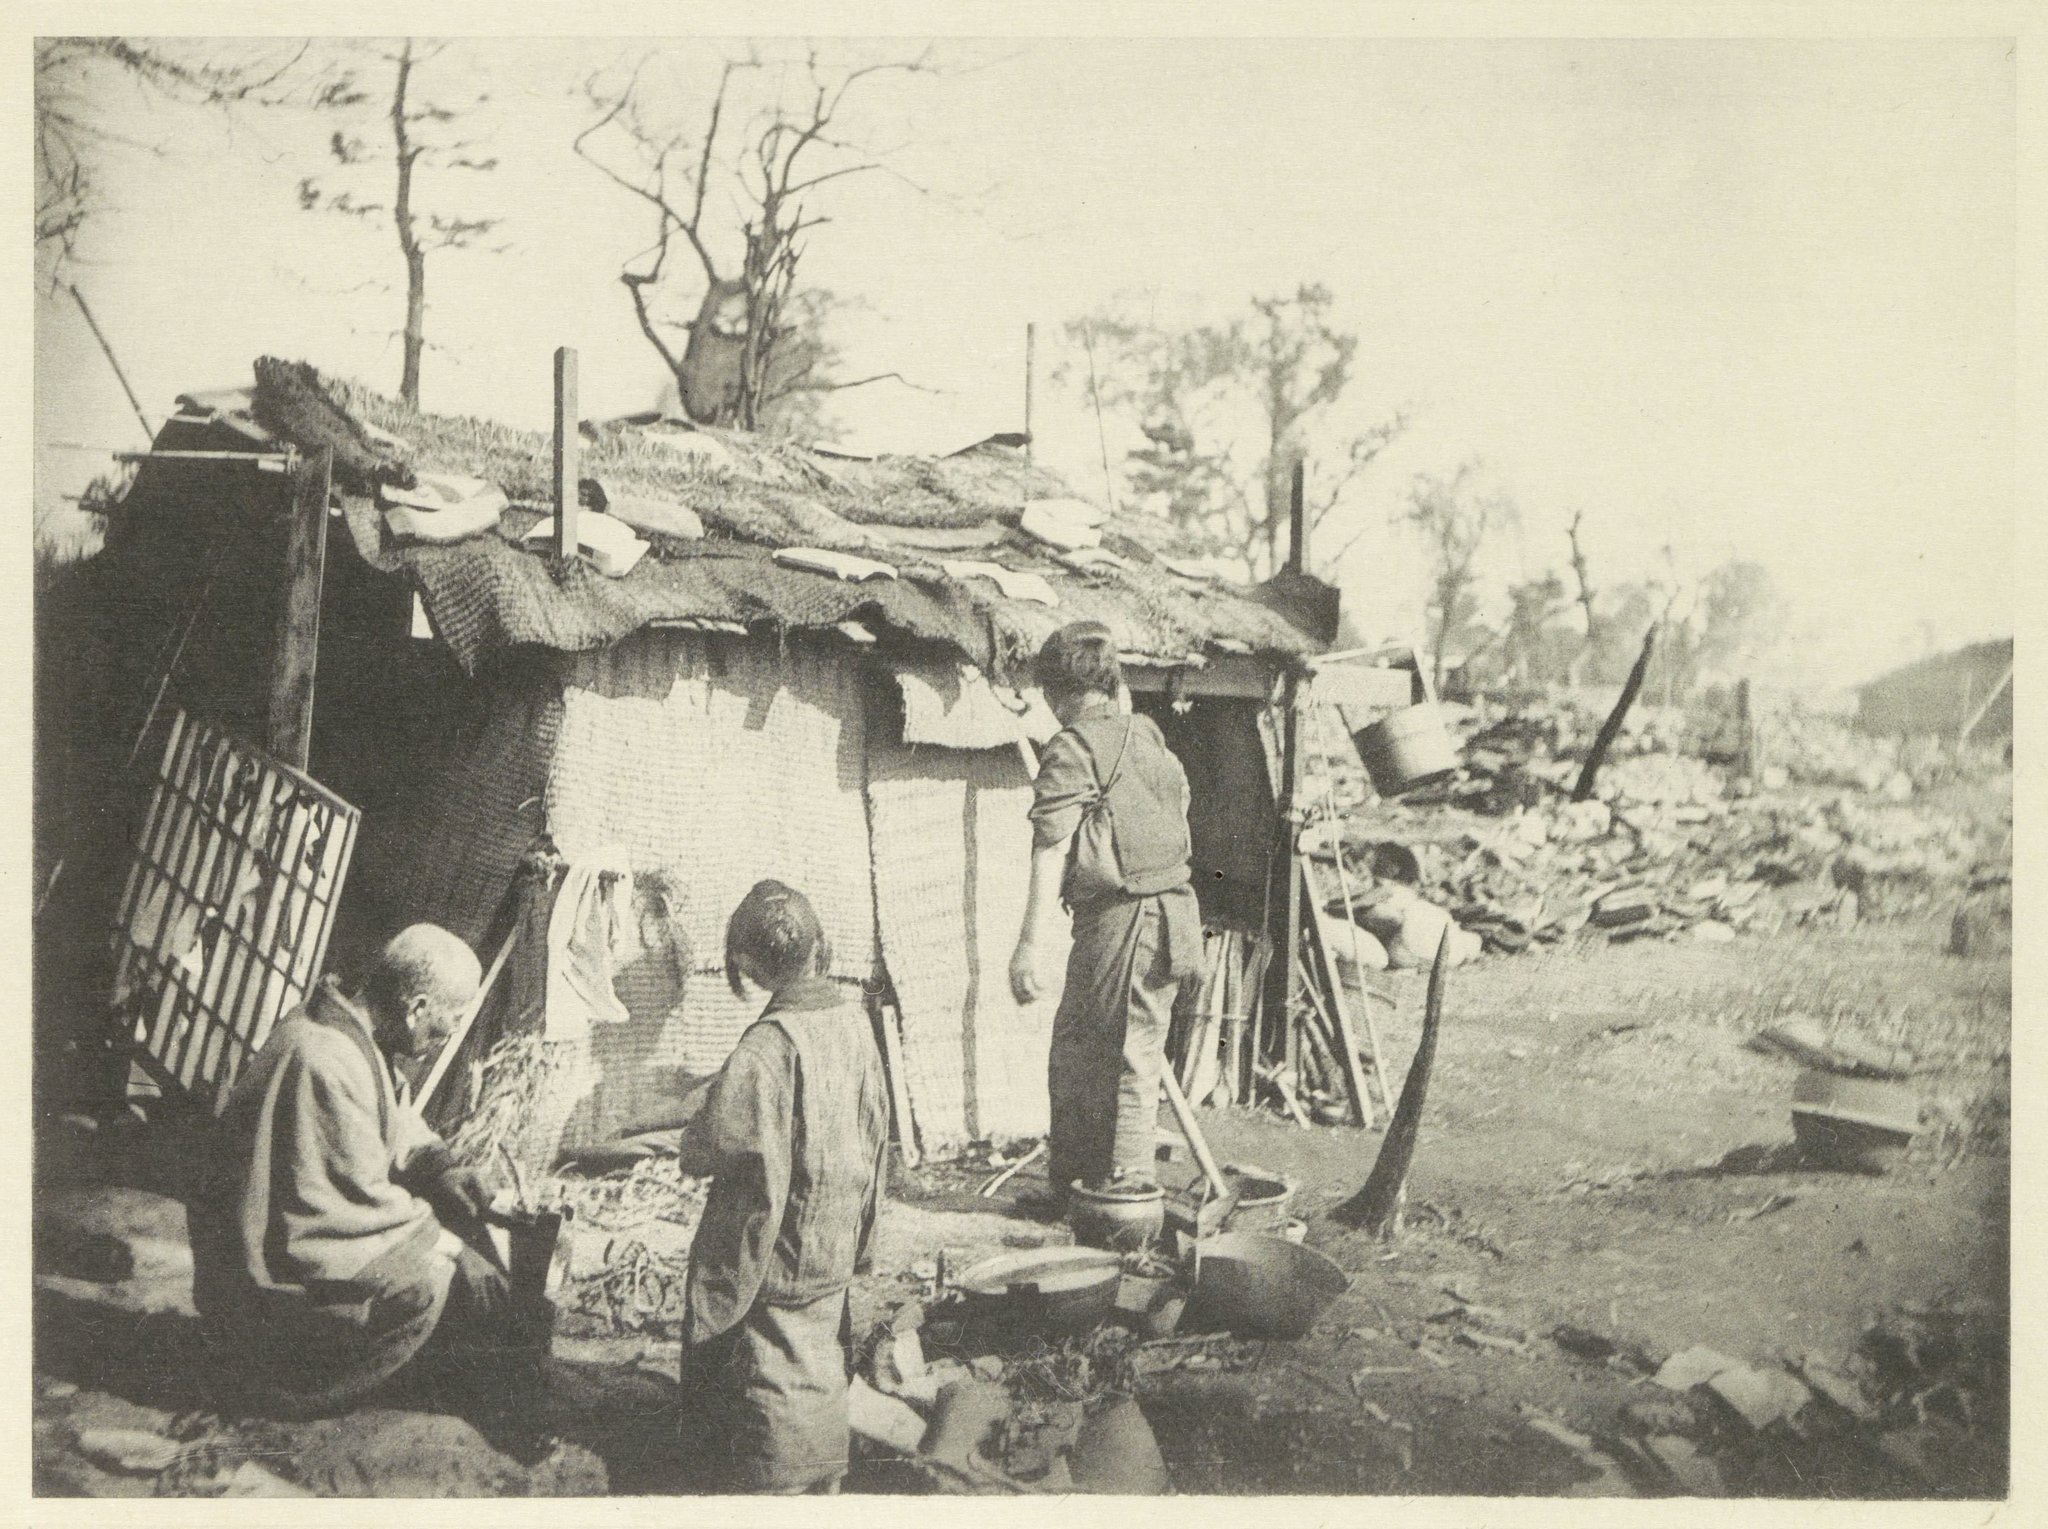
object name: page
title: Twee vrouwen en een man voor een tijdelijke woning te Japan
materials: paper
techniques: photograph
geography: japan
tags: consequences of an earthquake, housing